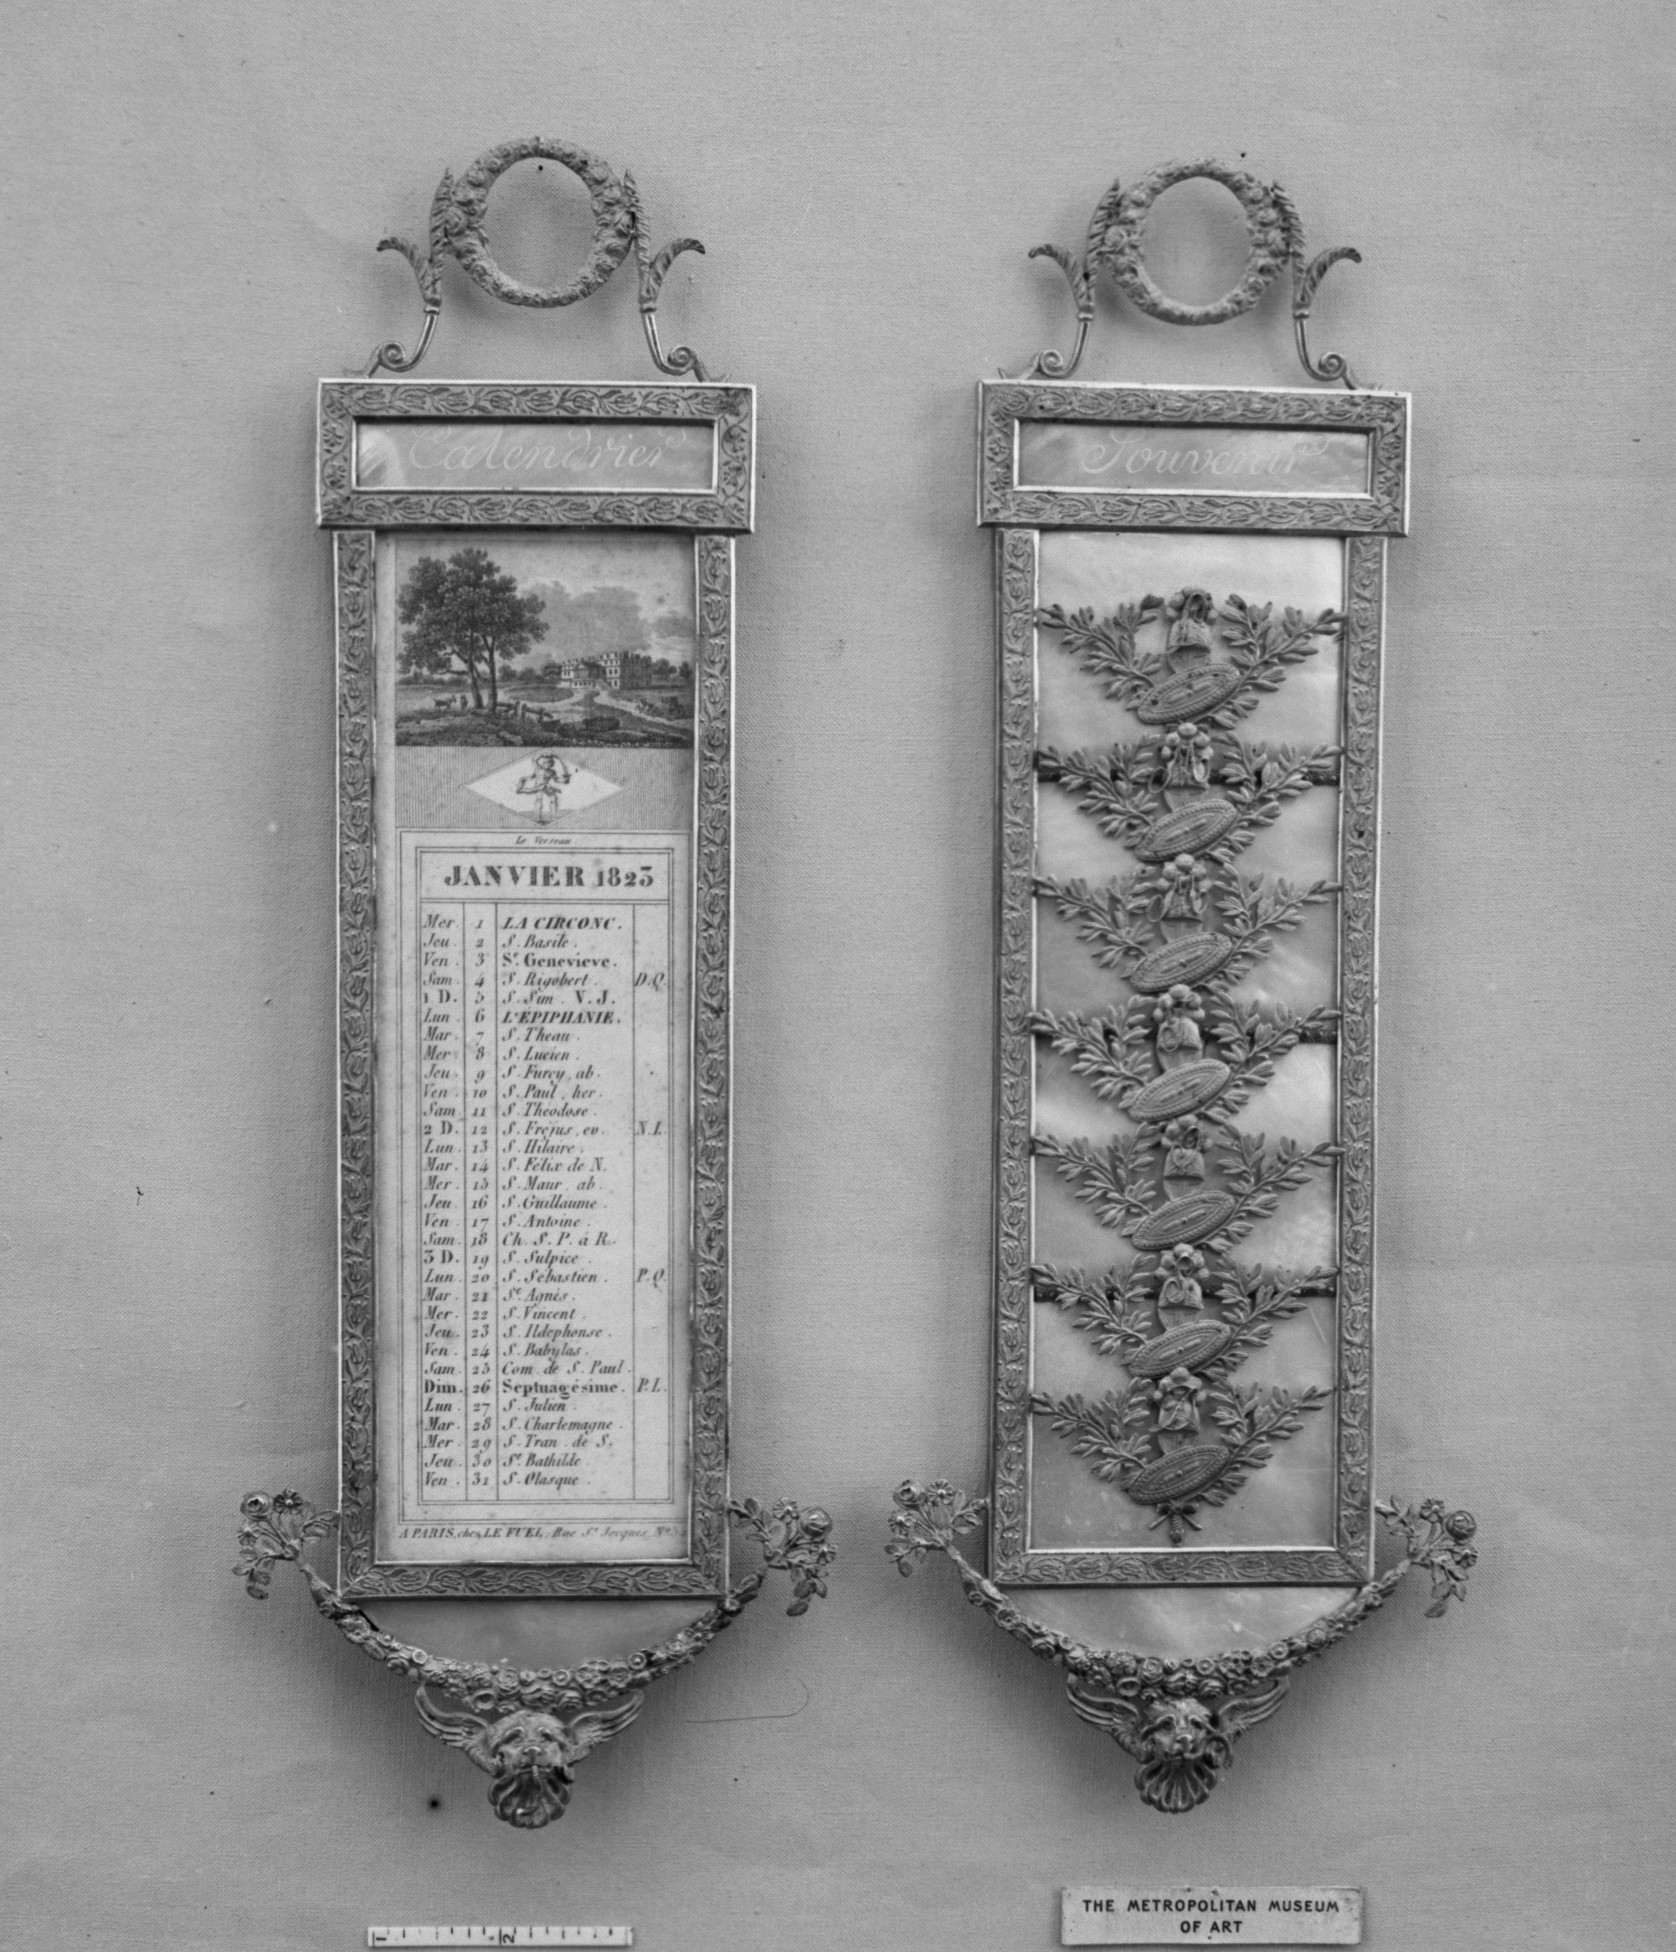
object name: frame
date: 1801-1900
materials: gilt bronze, mother of pearl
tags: calendars